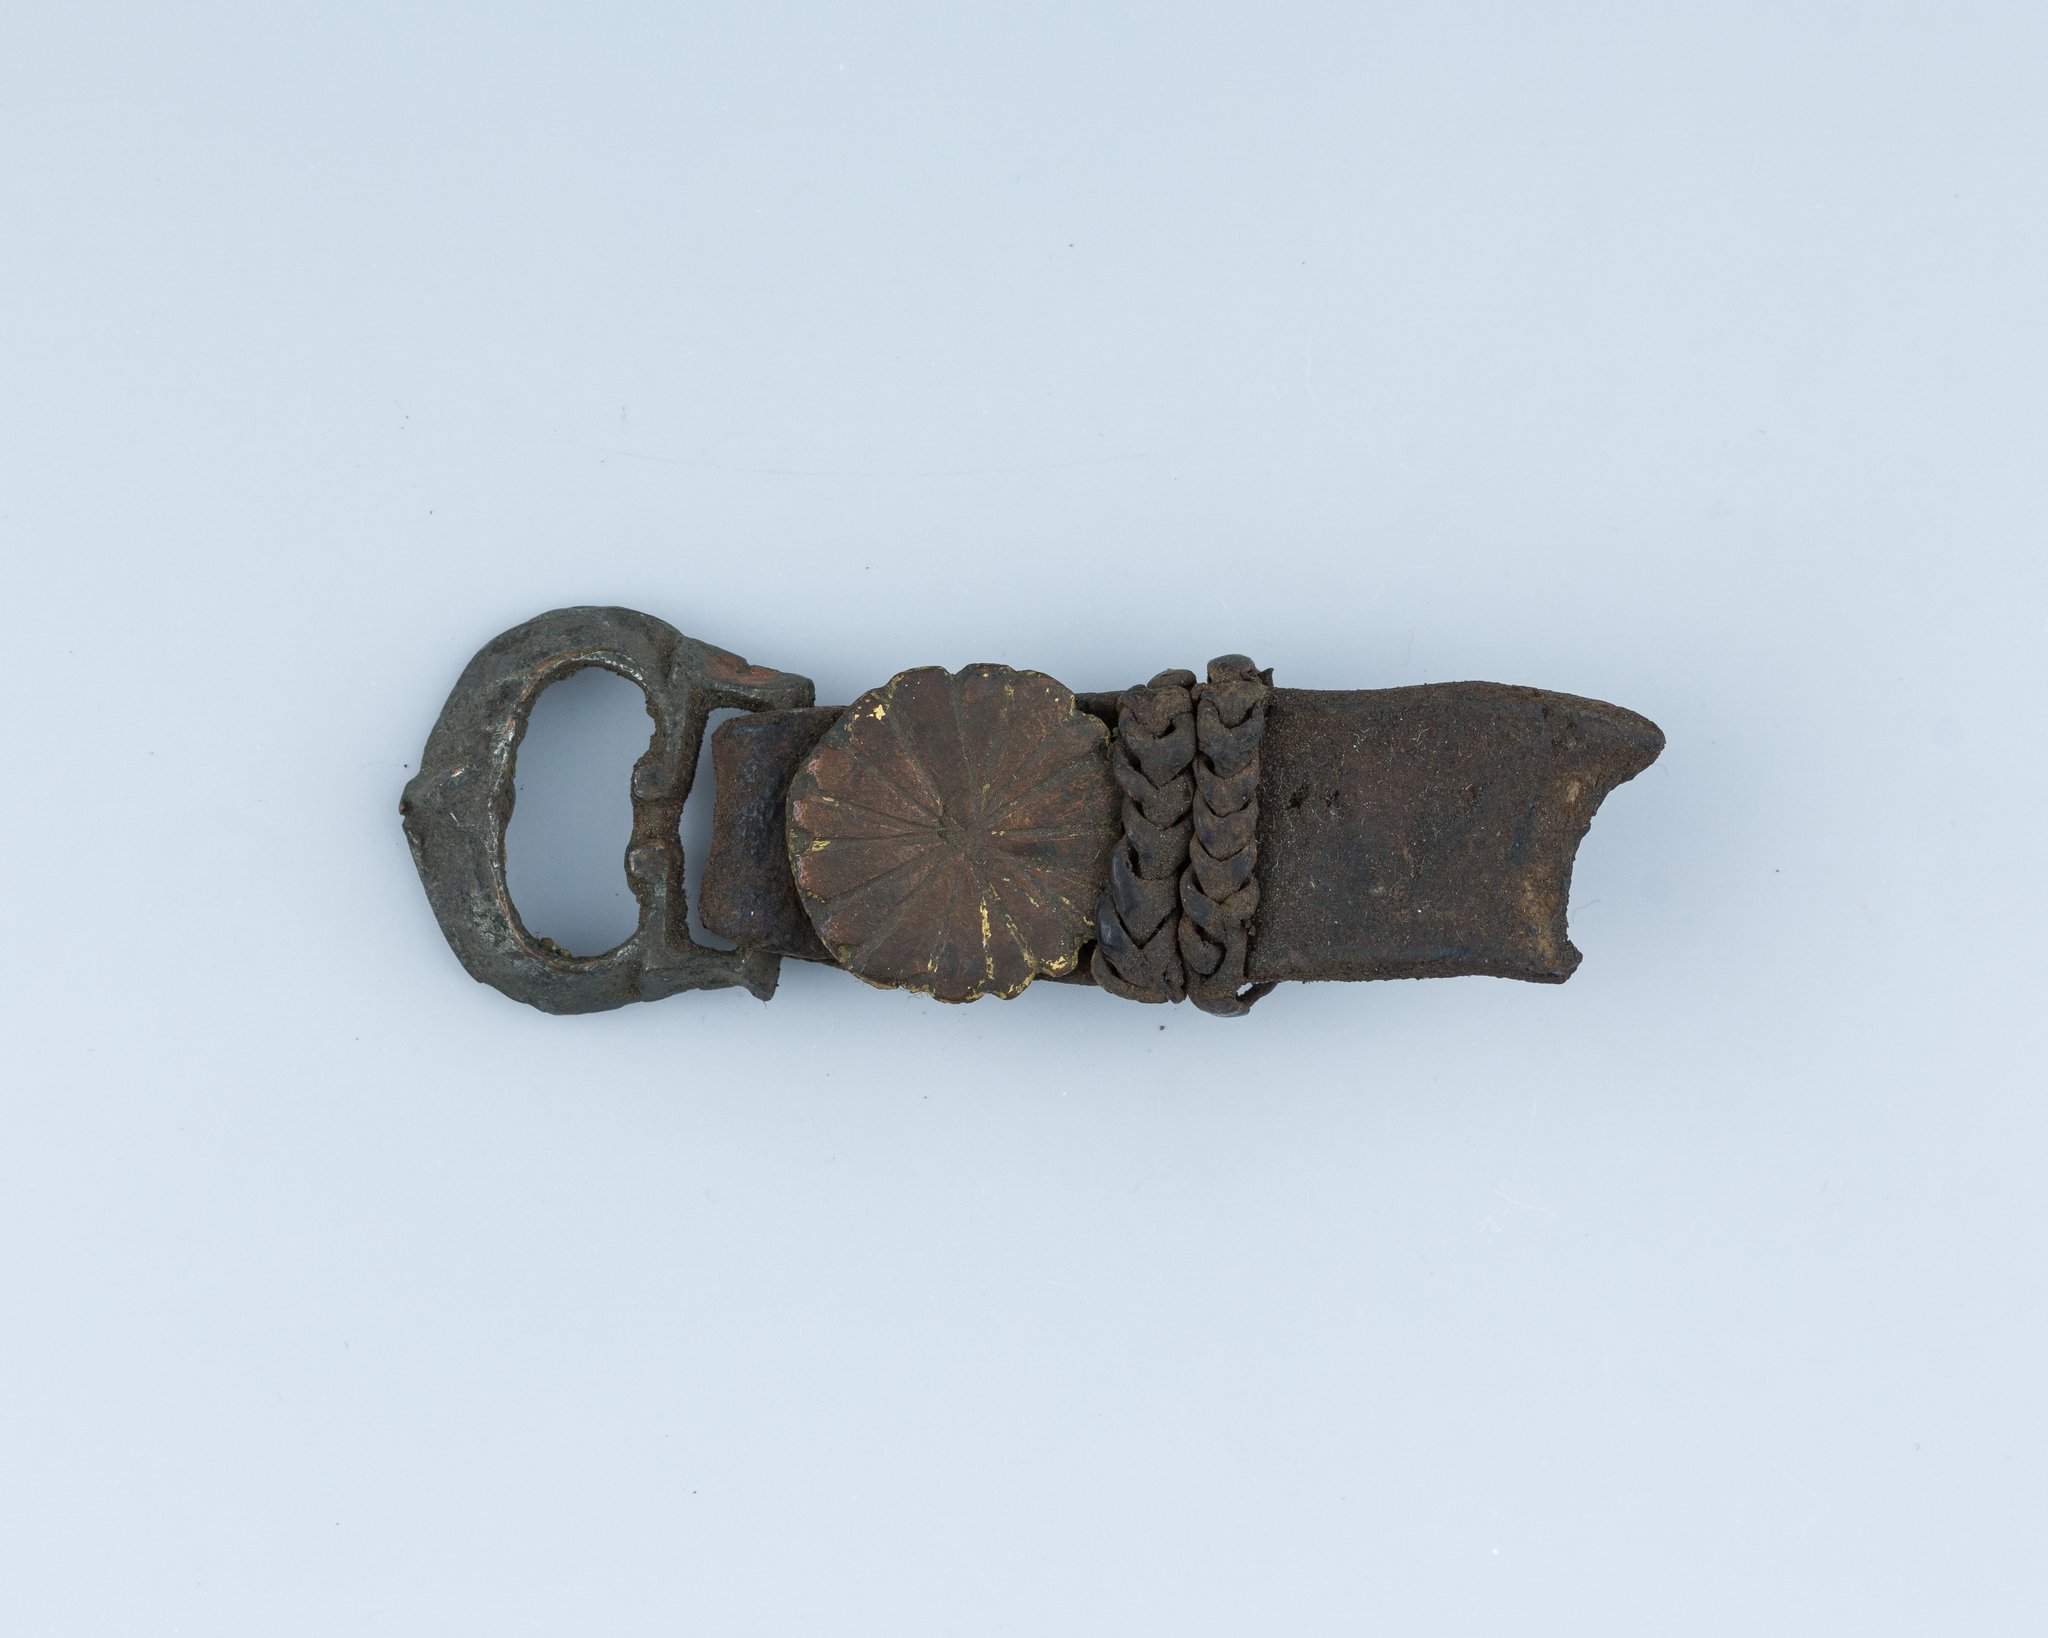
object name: buckle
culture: european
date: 1401-1700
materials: steel